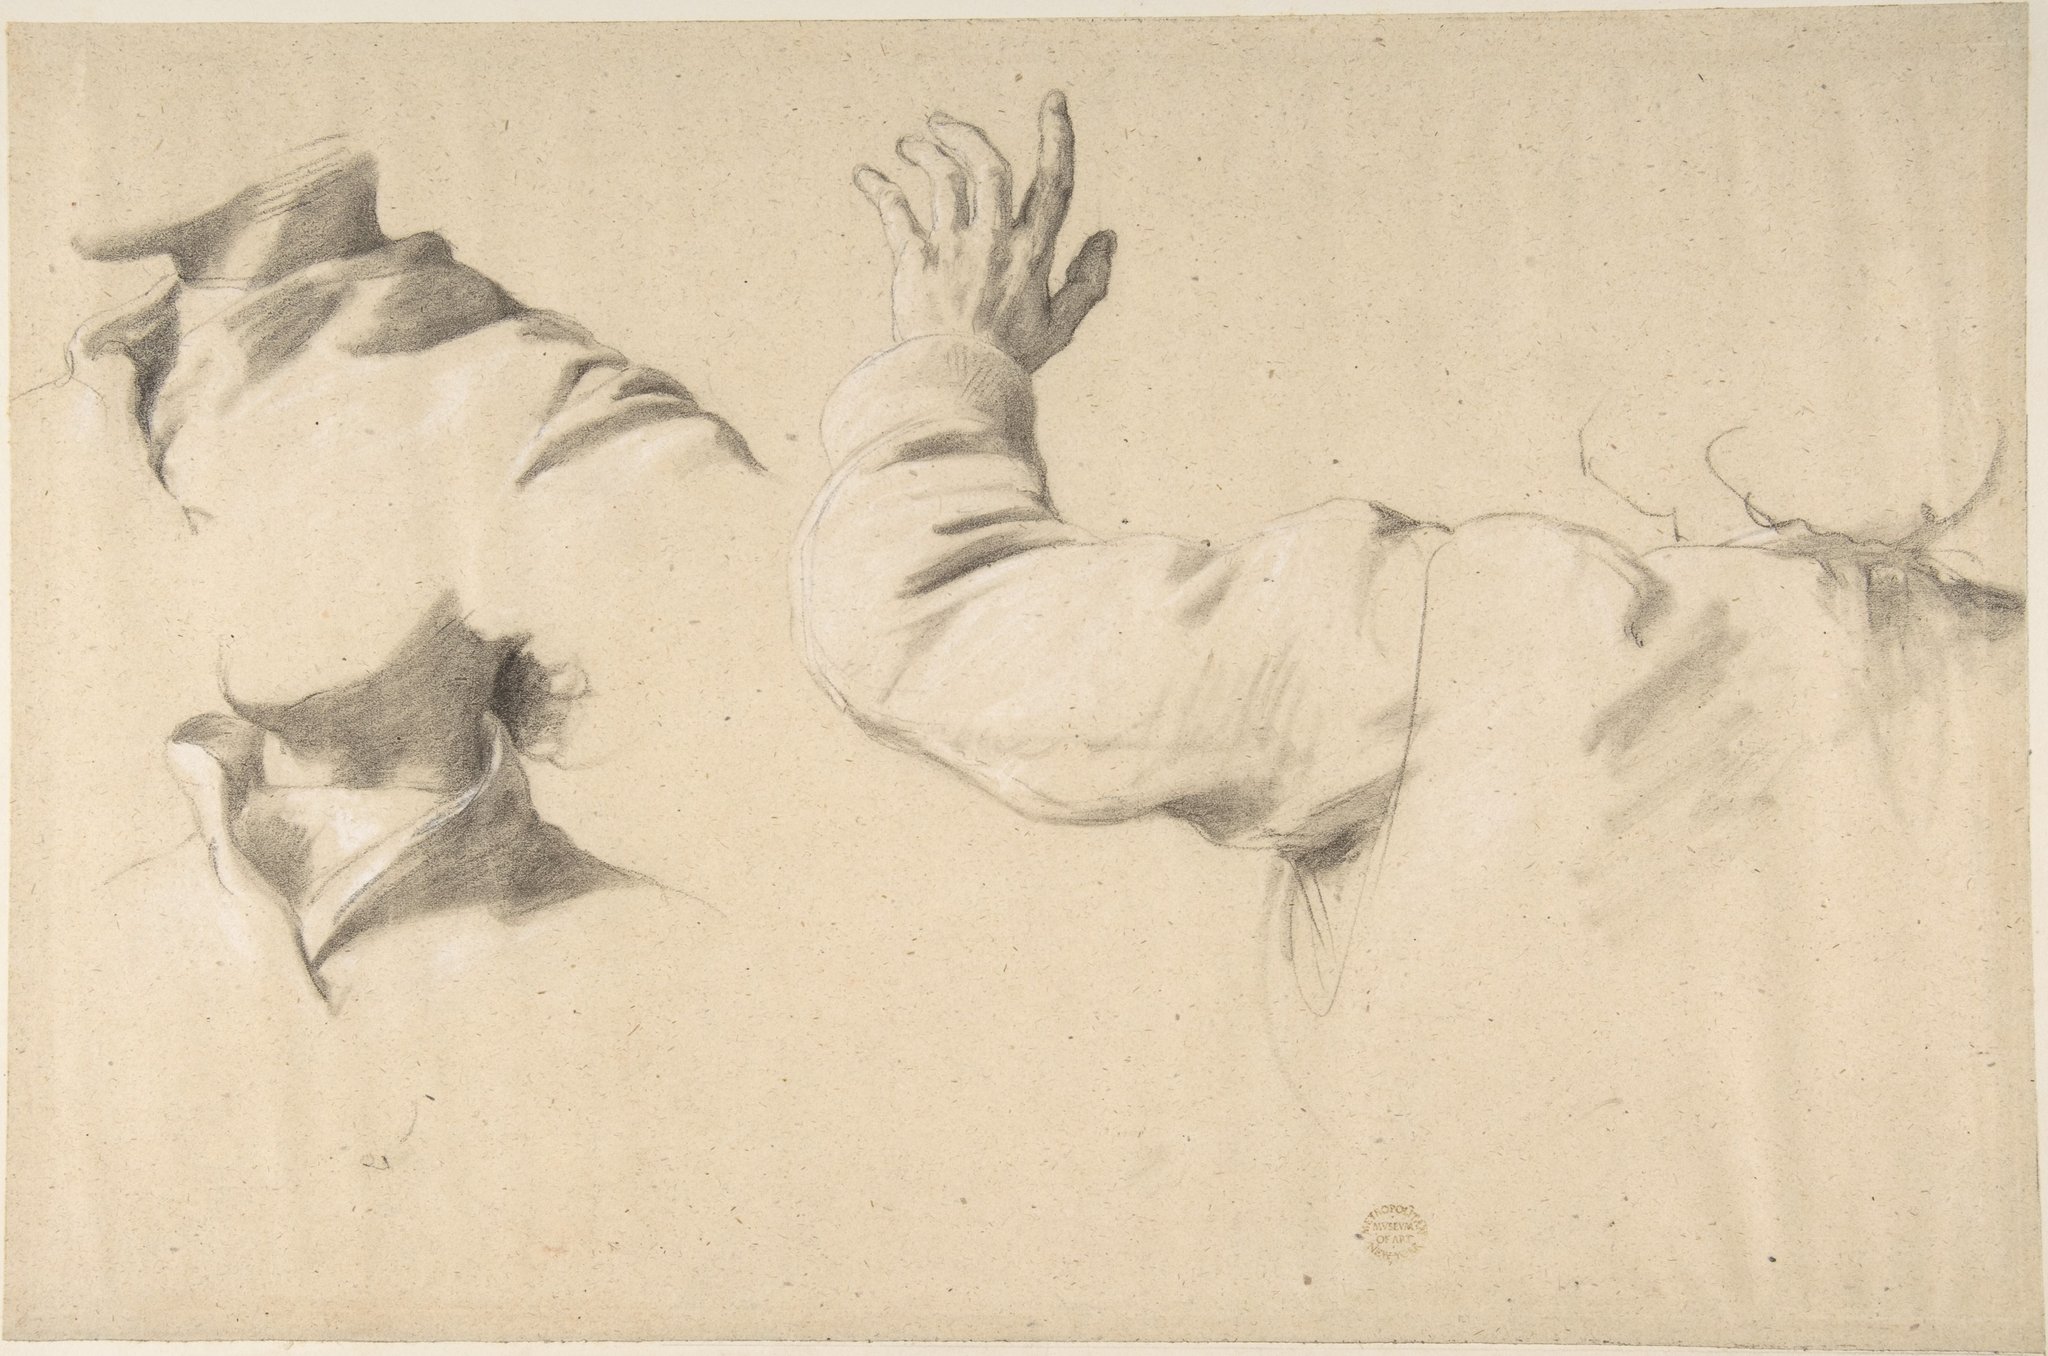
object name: drawing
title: Studies of Drapery in Sleeve and Collars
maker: romain cazes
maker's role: artist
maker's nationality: french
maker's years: 1808-1881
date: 1828-1881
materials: chalk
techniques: highlighting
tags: hands